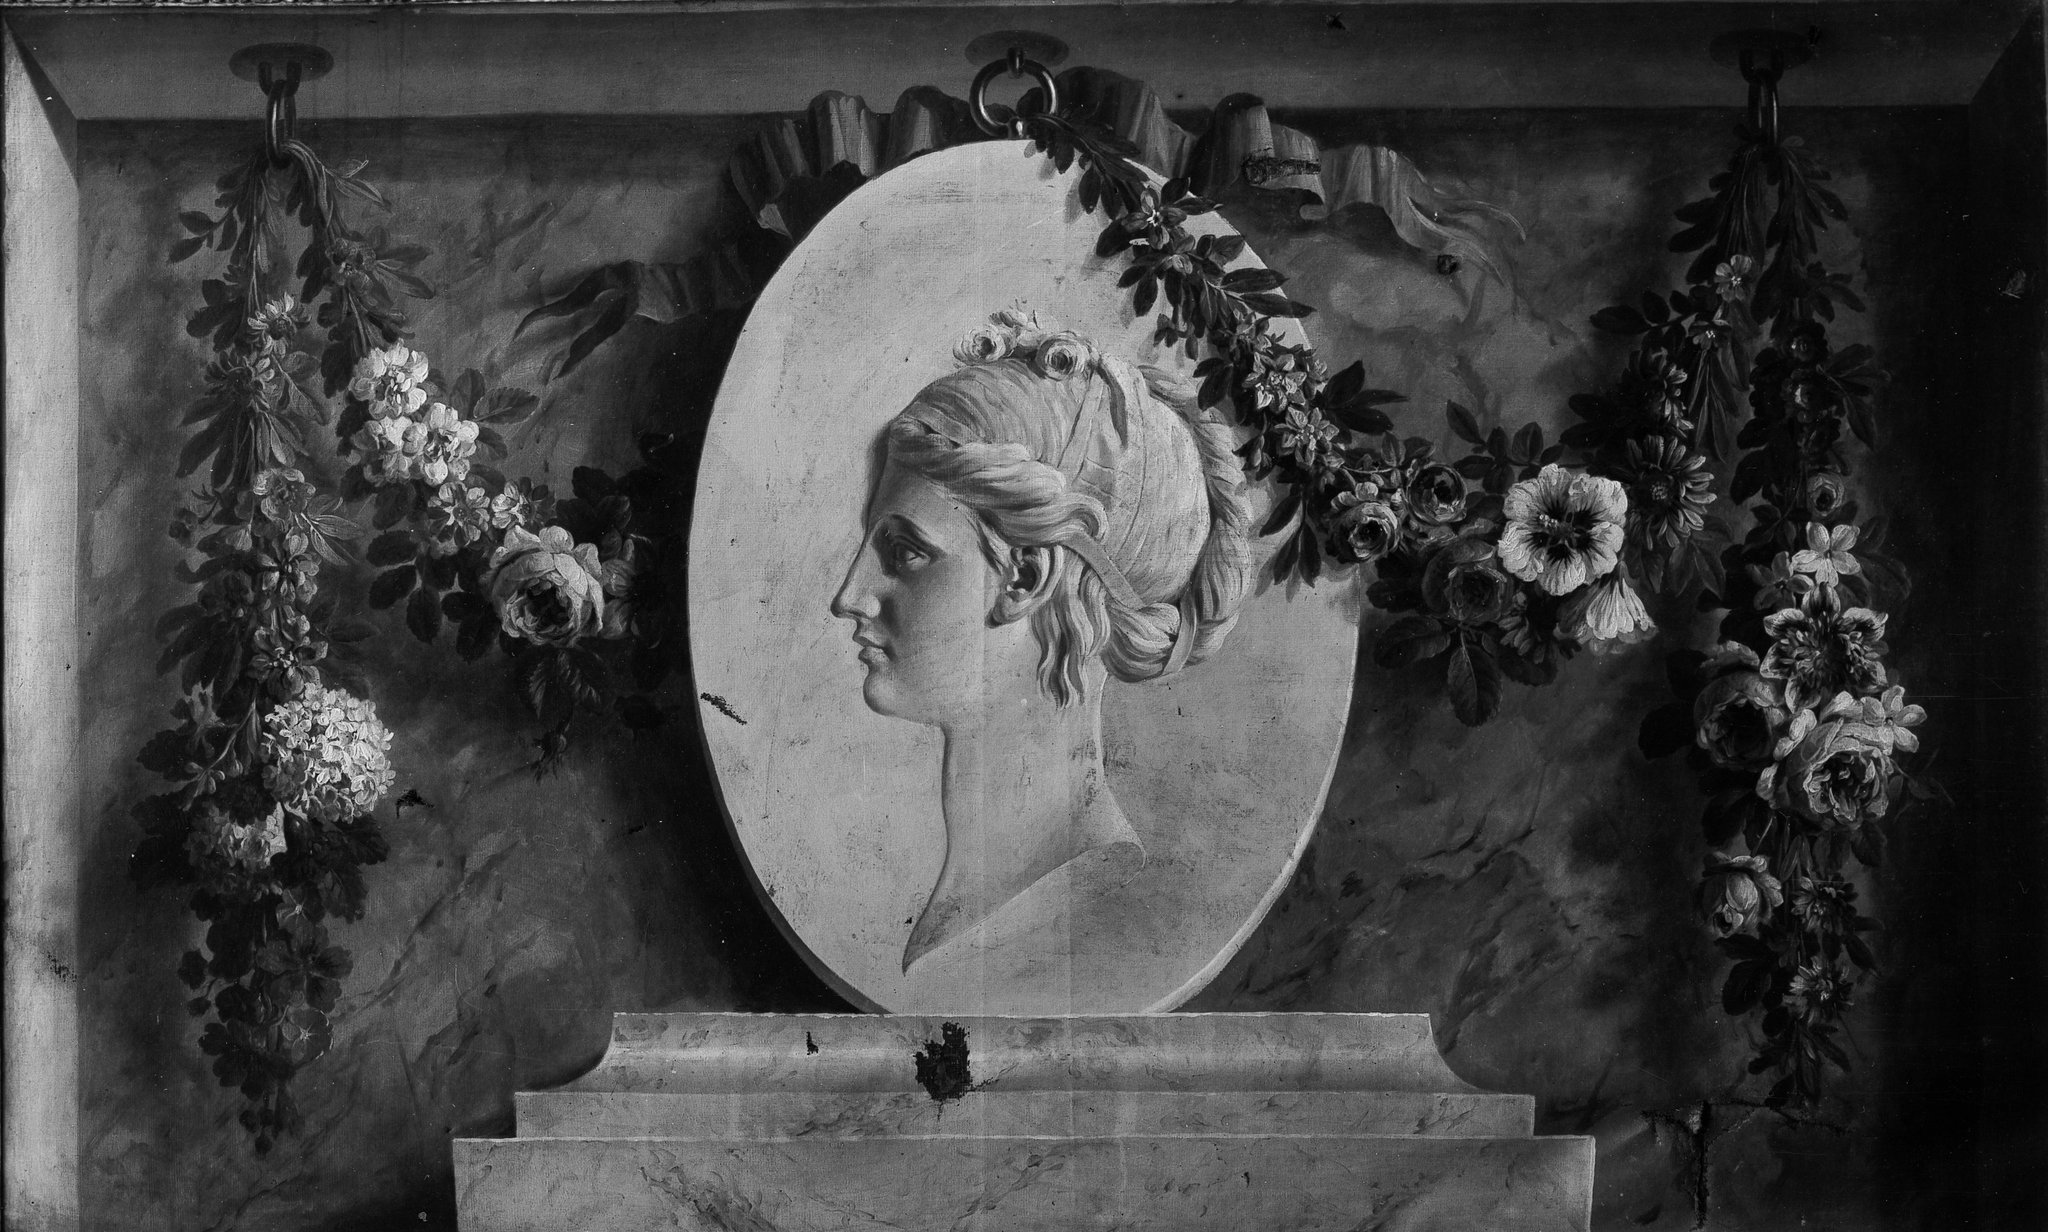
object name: overdoor panel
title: Female bust in an oval medallion draped with a garland (one of a pair)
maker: french painter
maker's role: artist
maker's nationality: french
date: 1770-1775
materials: canvas, oil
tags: garlands,profiles,women